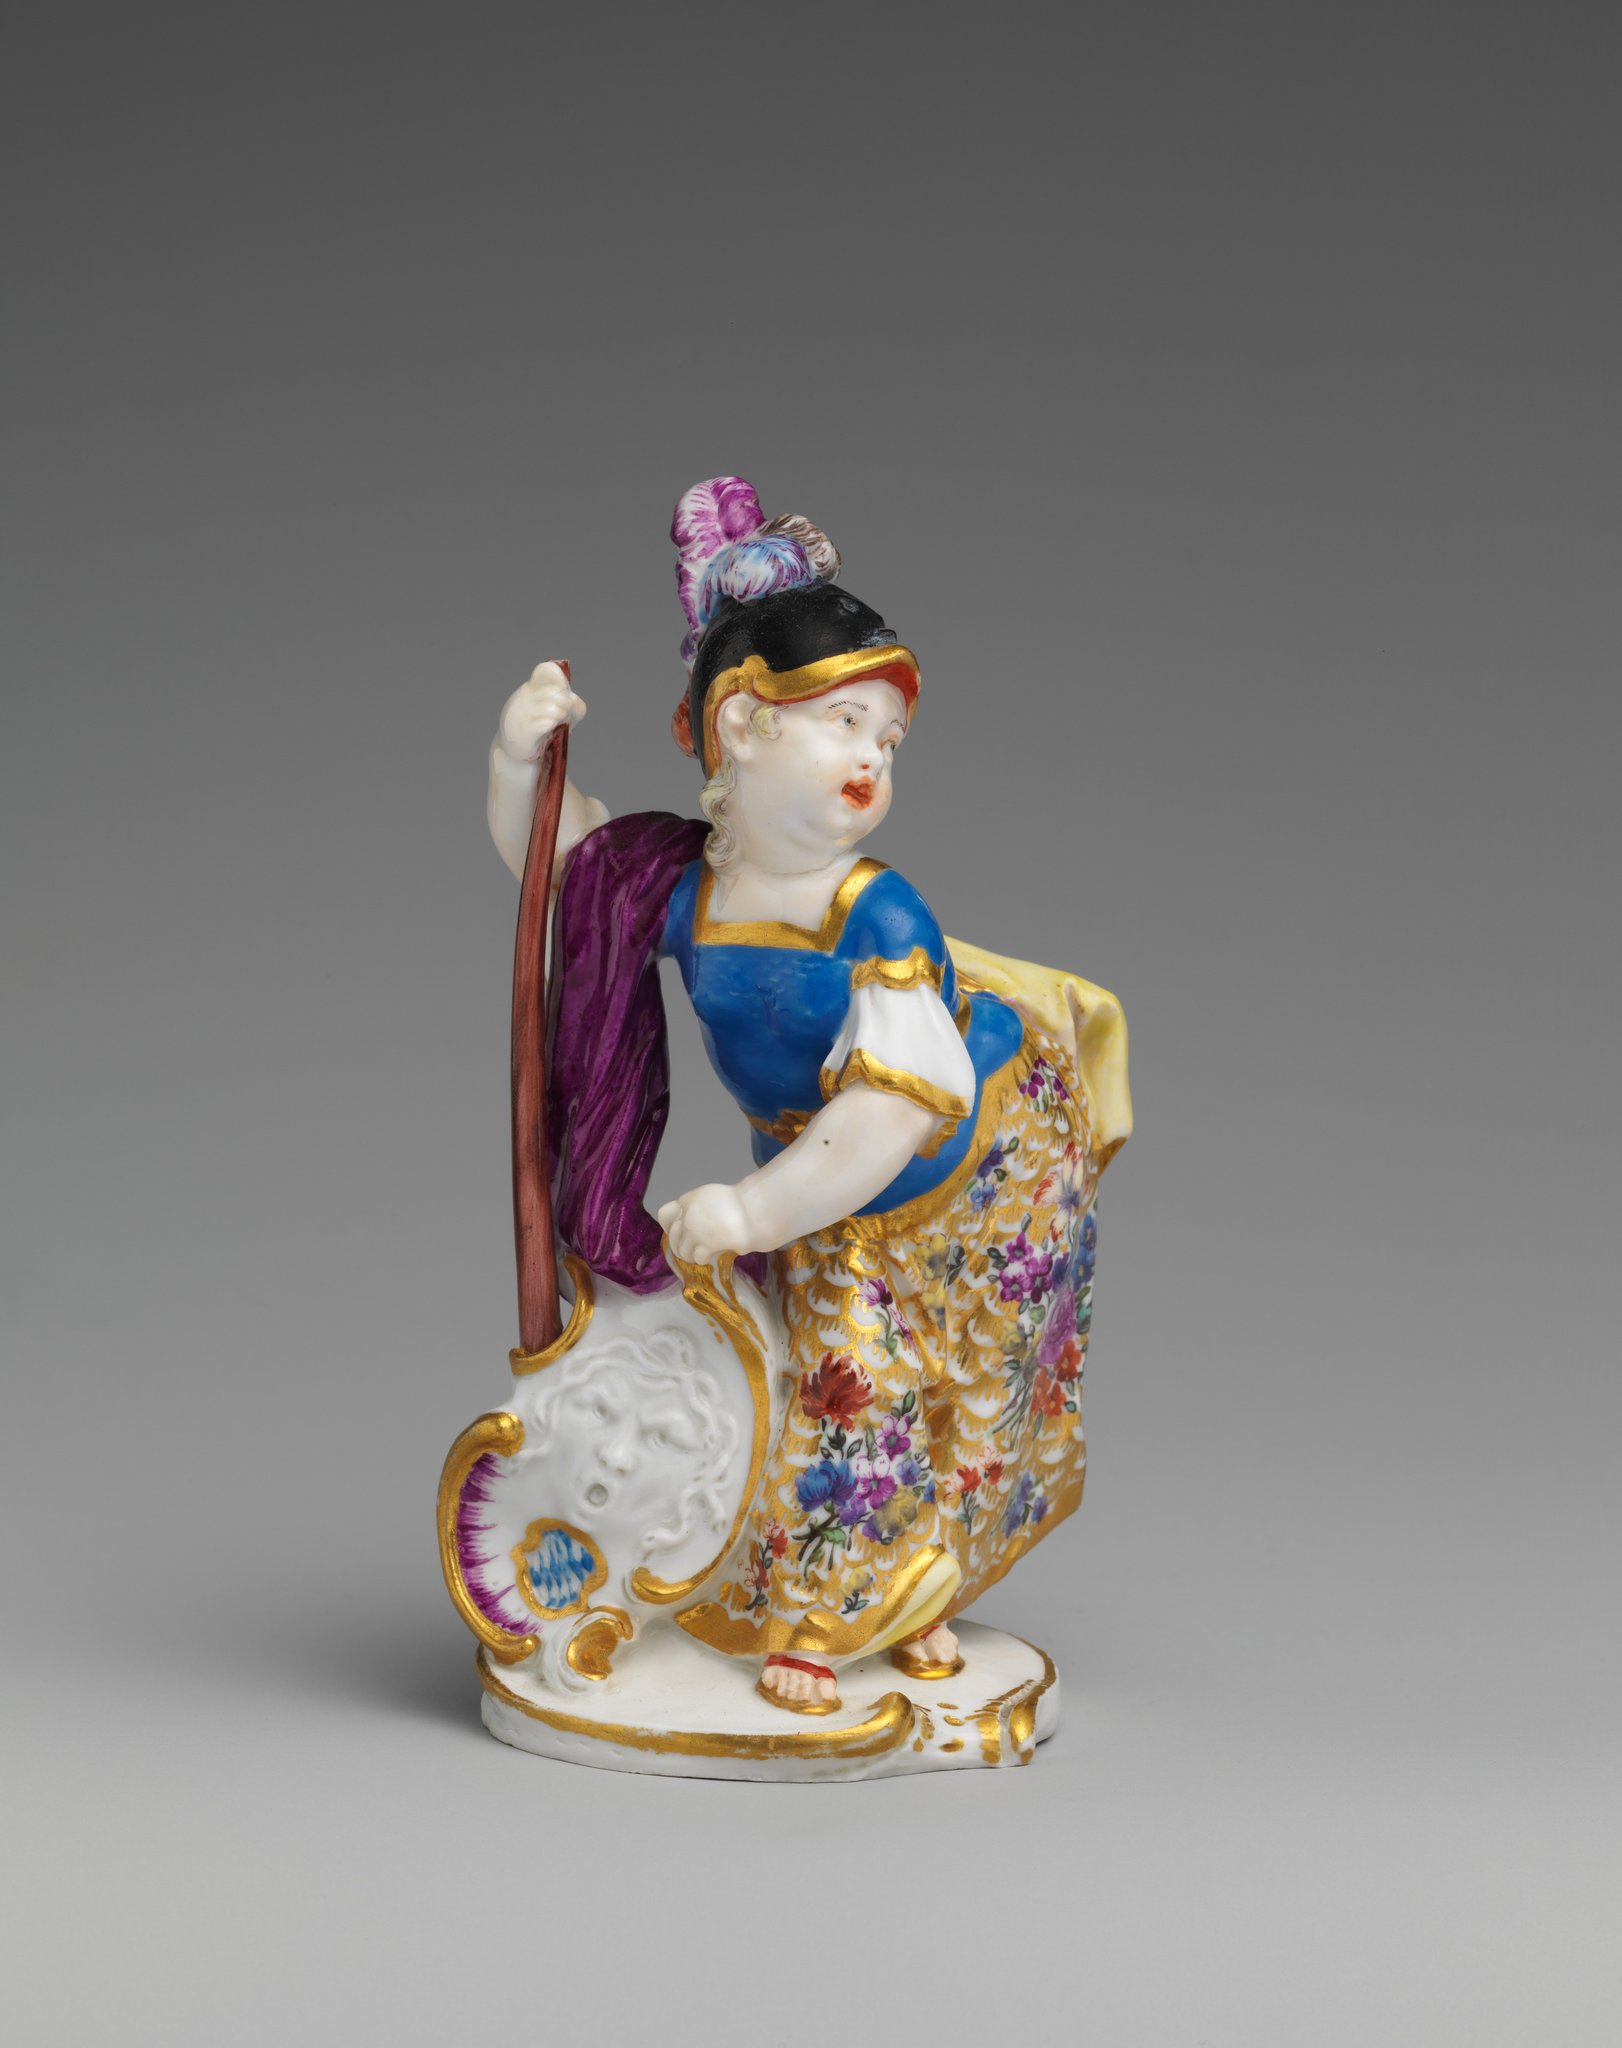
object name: figure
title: Minerva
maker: nymphenburg porcelain manufactory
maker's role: manufactory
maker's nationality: german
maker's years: 1747-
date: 1760-1765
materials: hard paste porcelain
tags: minerva